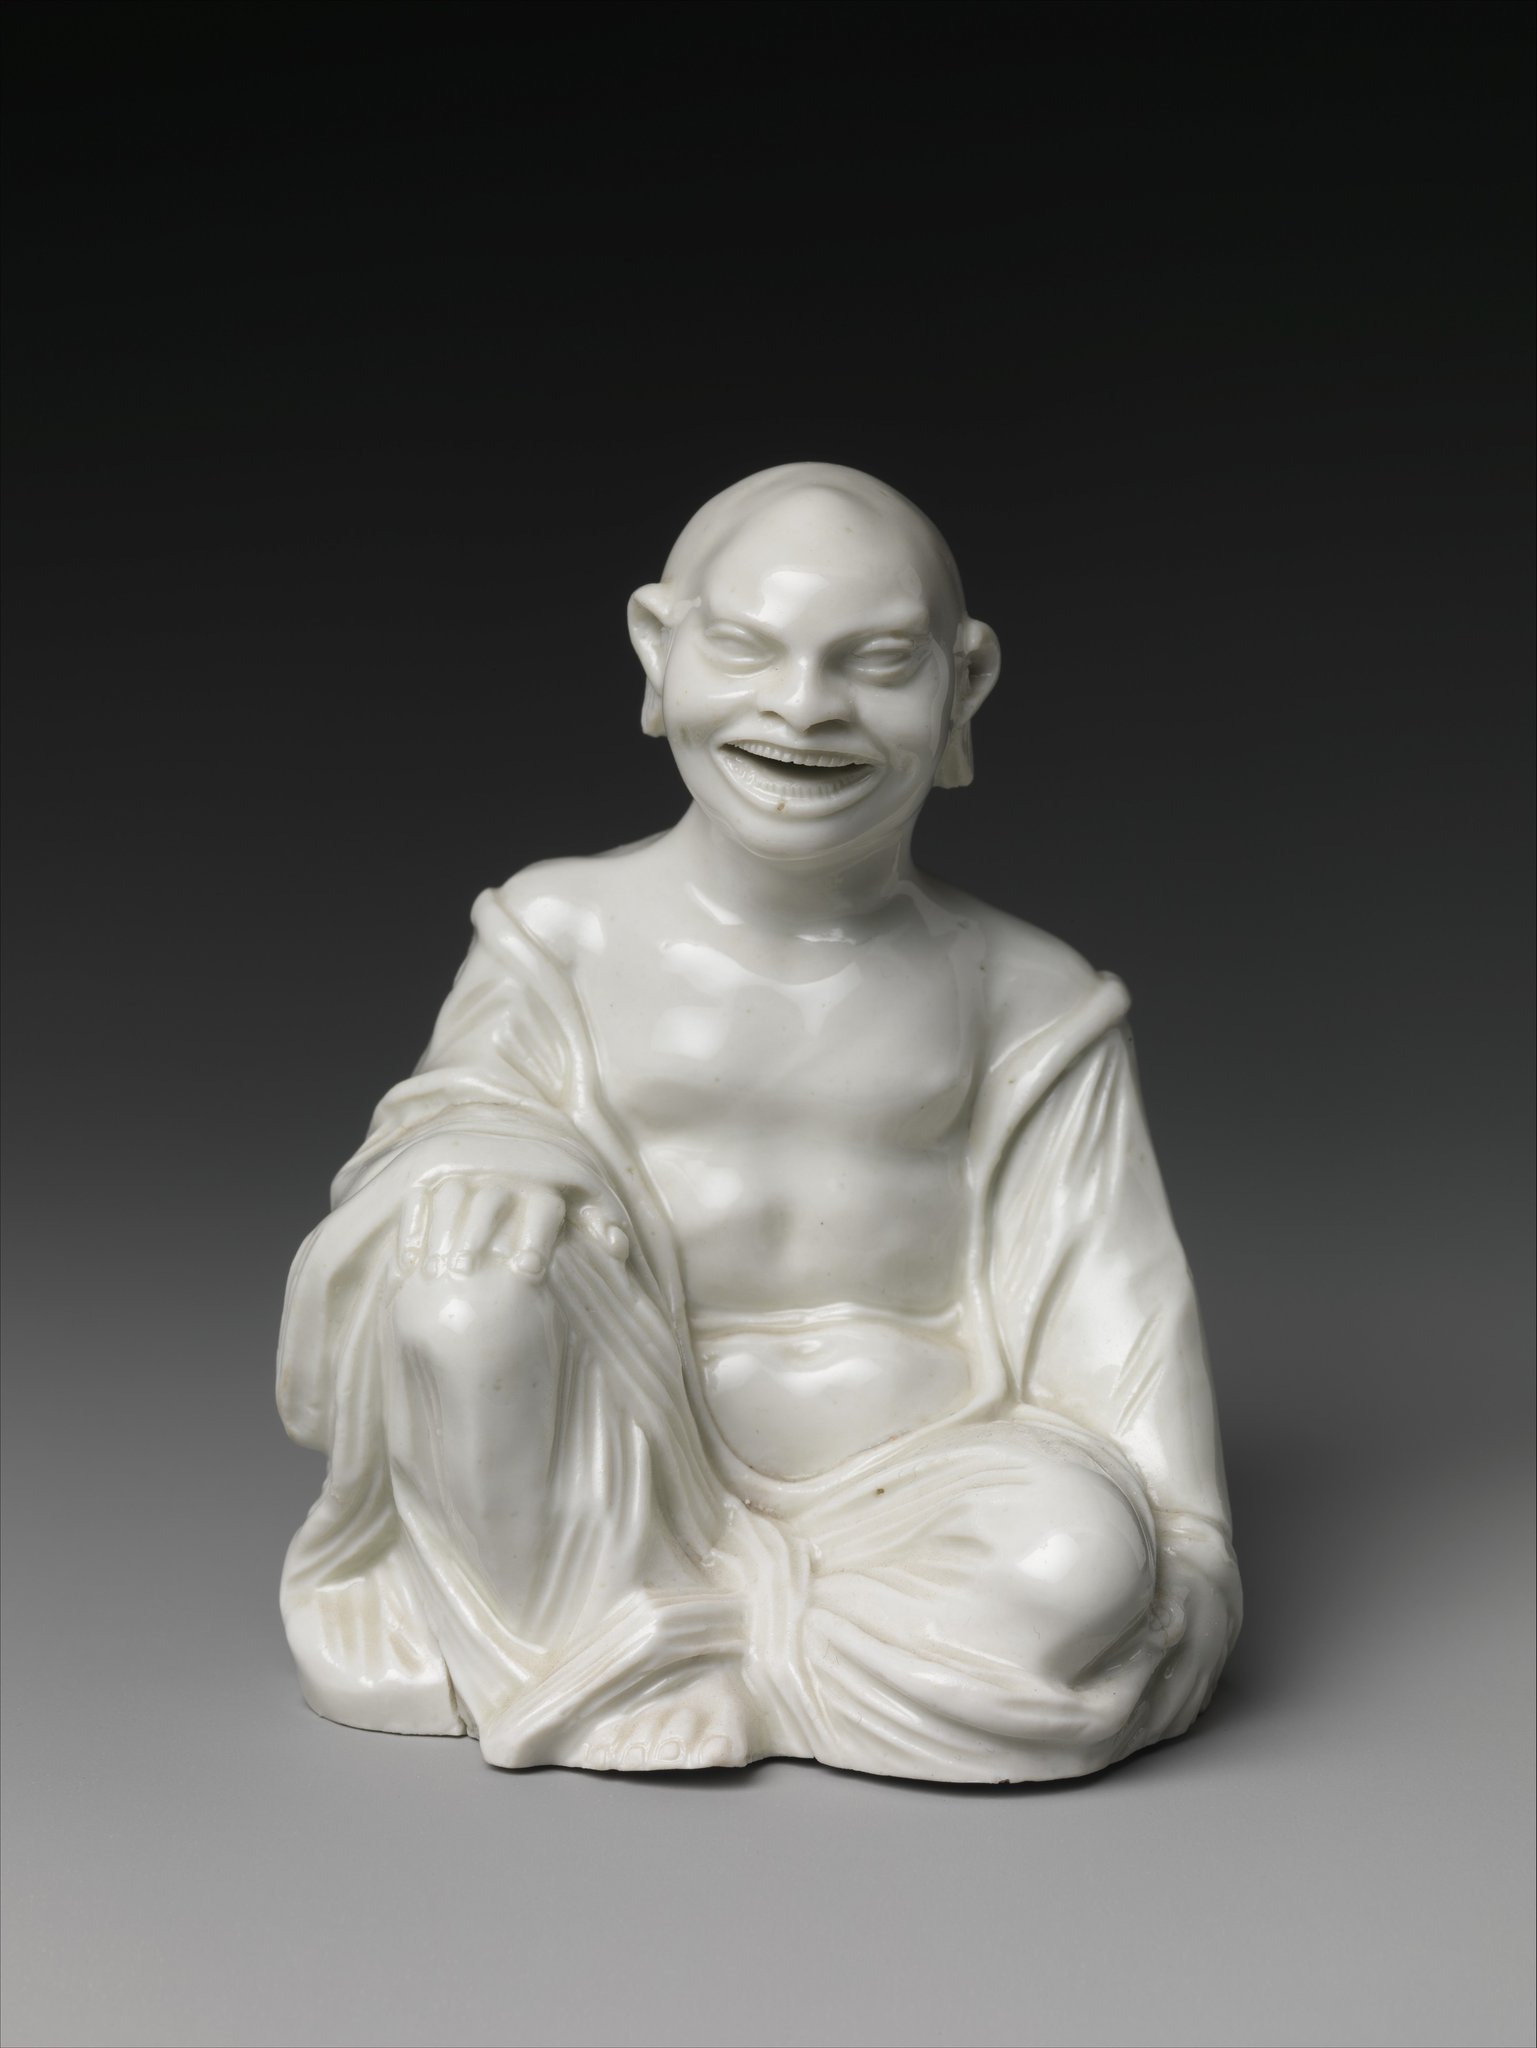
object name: figure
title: Buddhist Divinity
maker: meissen manufactory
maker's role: manufactory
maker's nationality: german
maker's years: 1710-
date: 1710-1720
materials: hard paste porcelain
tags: men,buddhism